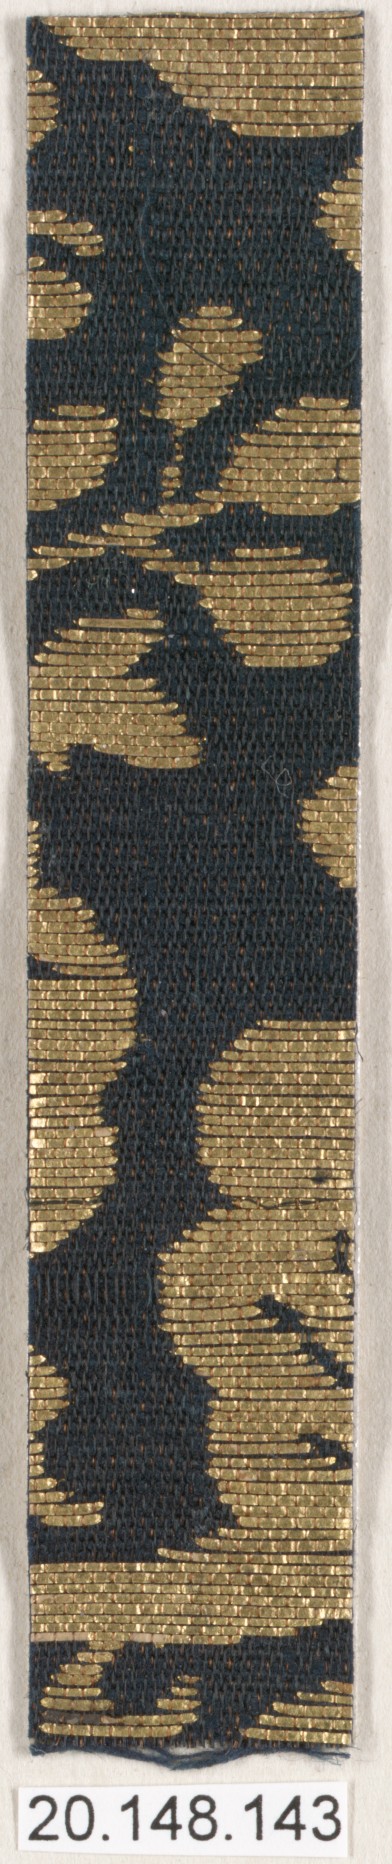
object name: piece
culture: japanese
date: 1601-1700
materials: silk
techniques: compound weave